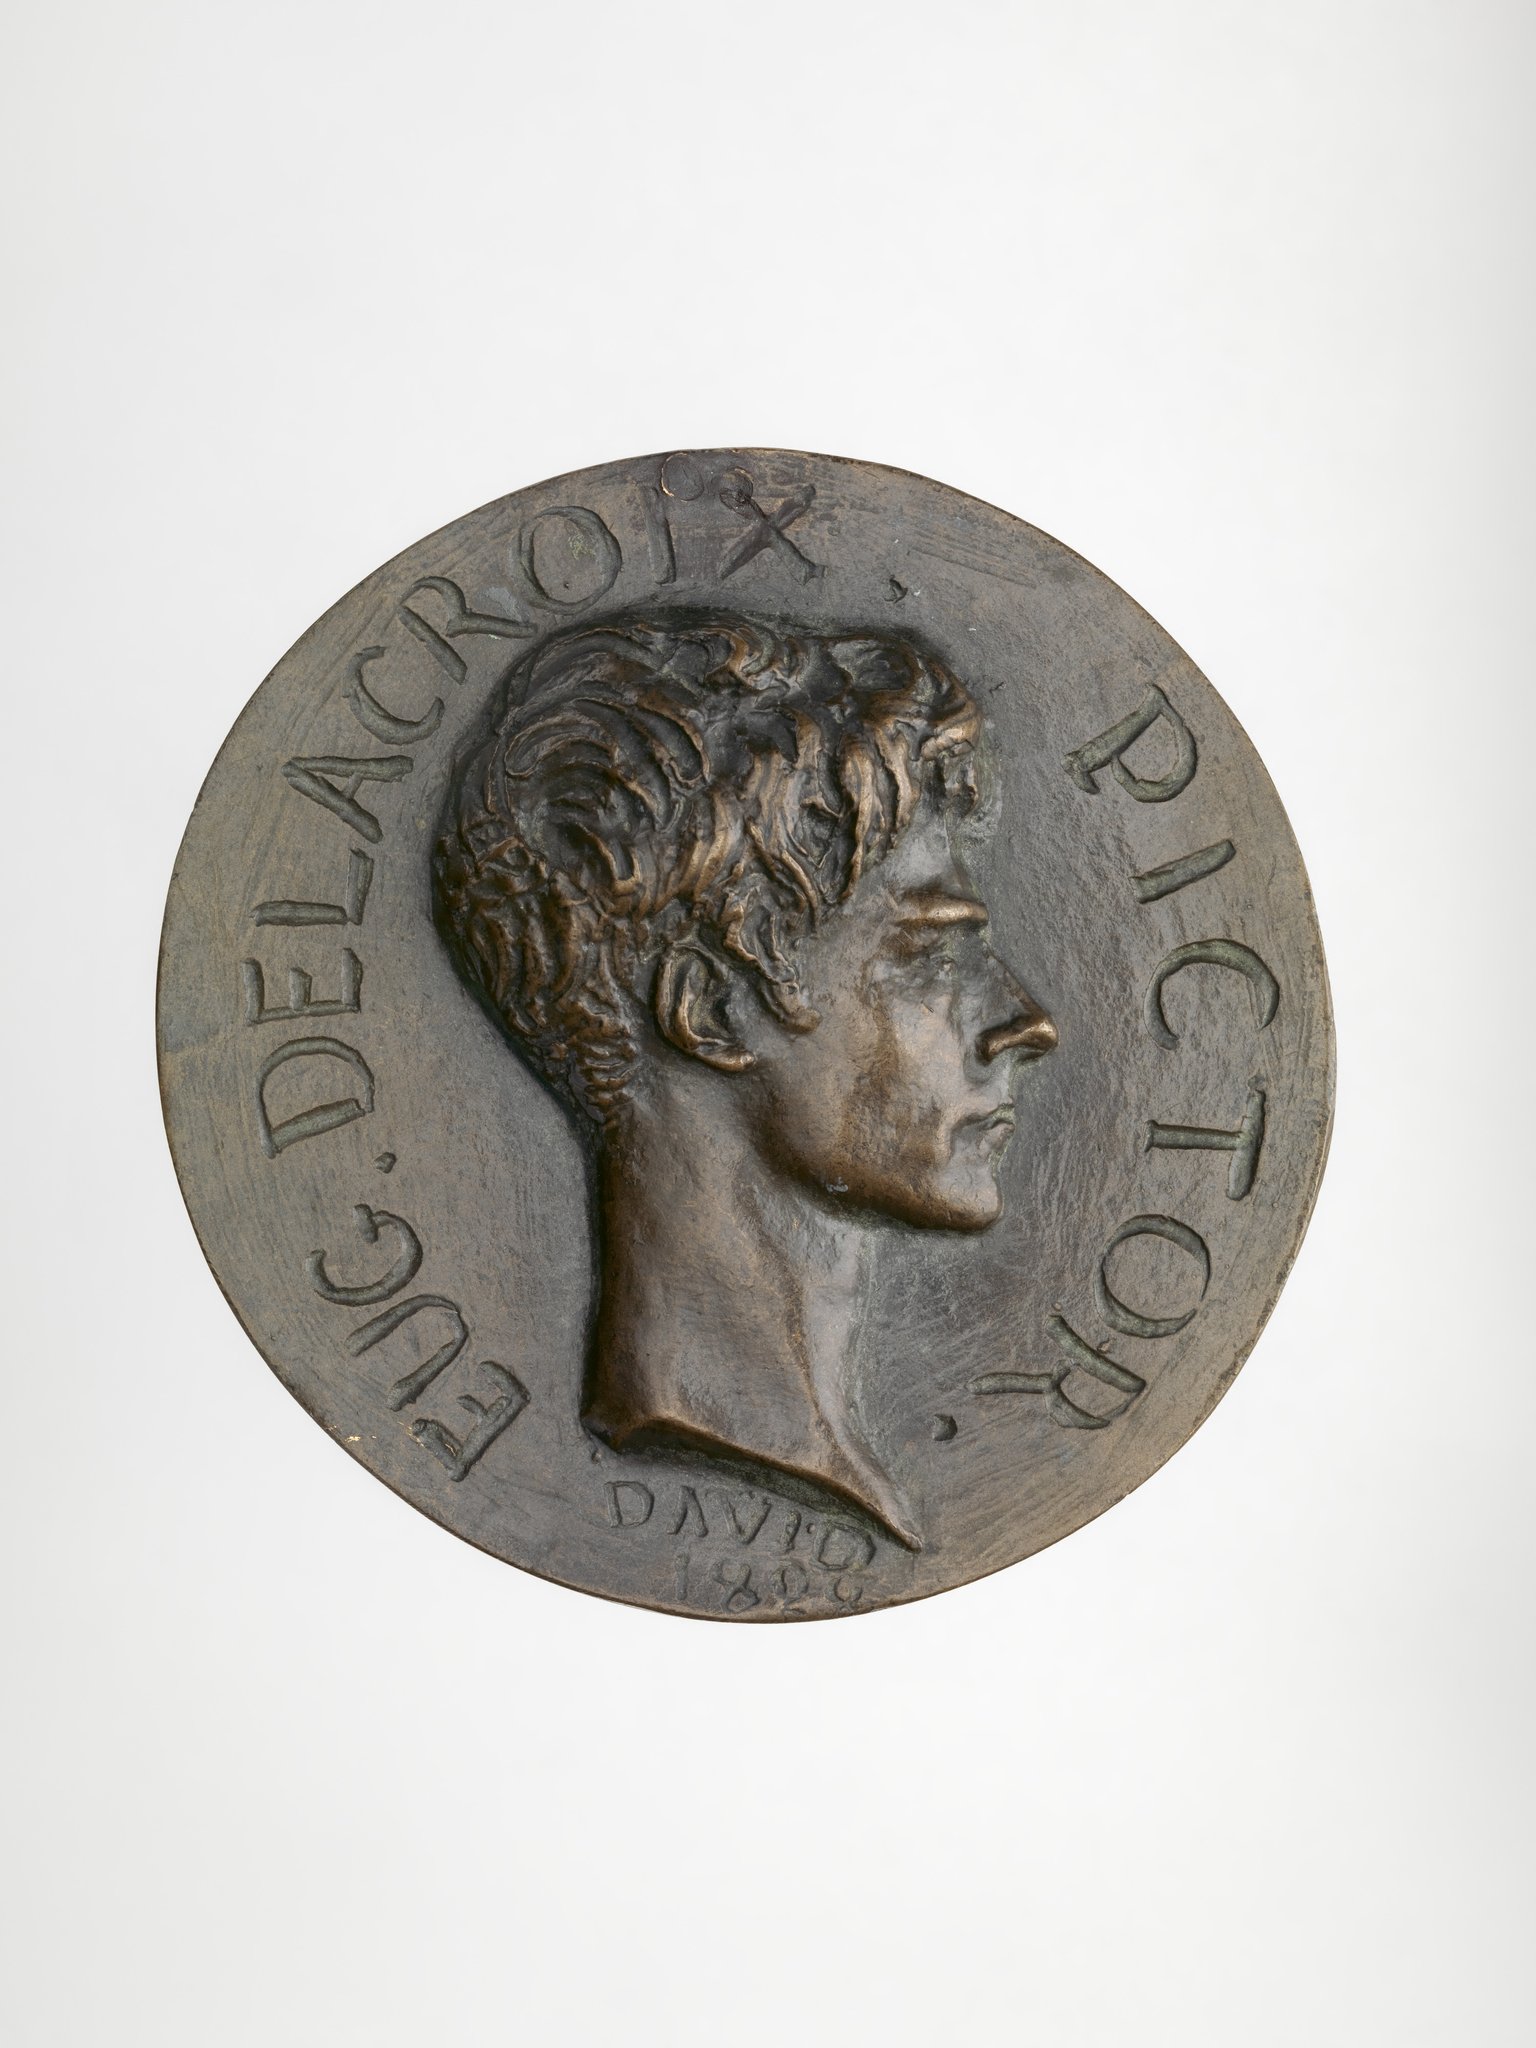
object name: medallion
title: Ferdinand Victor Eugène Delacroix (1798–1863)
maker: pierre jean david d'angers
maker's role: artist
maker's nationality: french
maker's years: 1788-1856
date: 1828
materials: bronze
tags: men,profiles